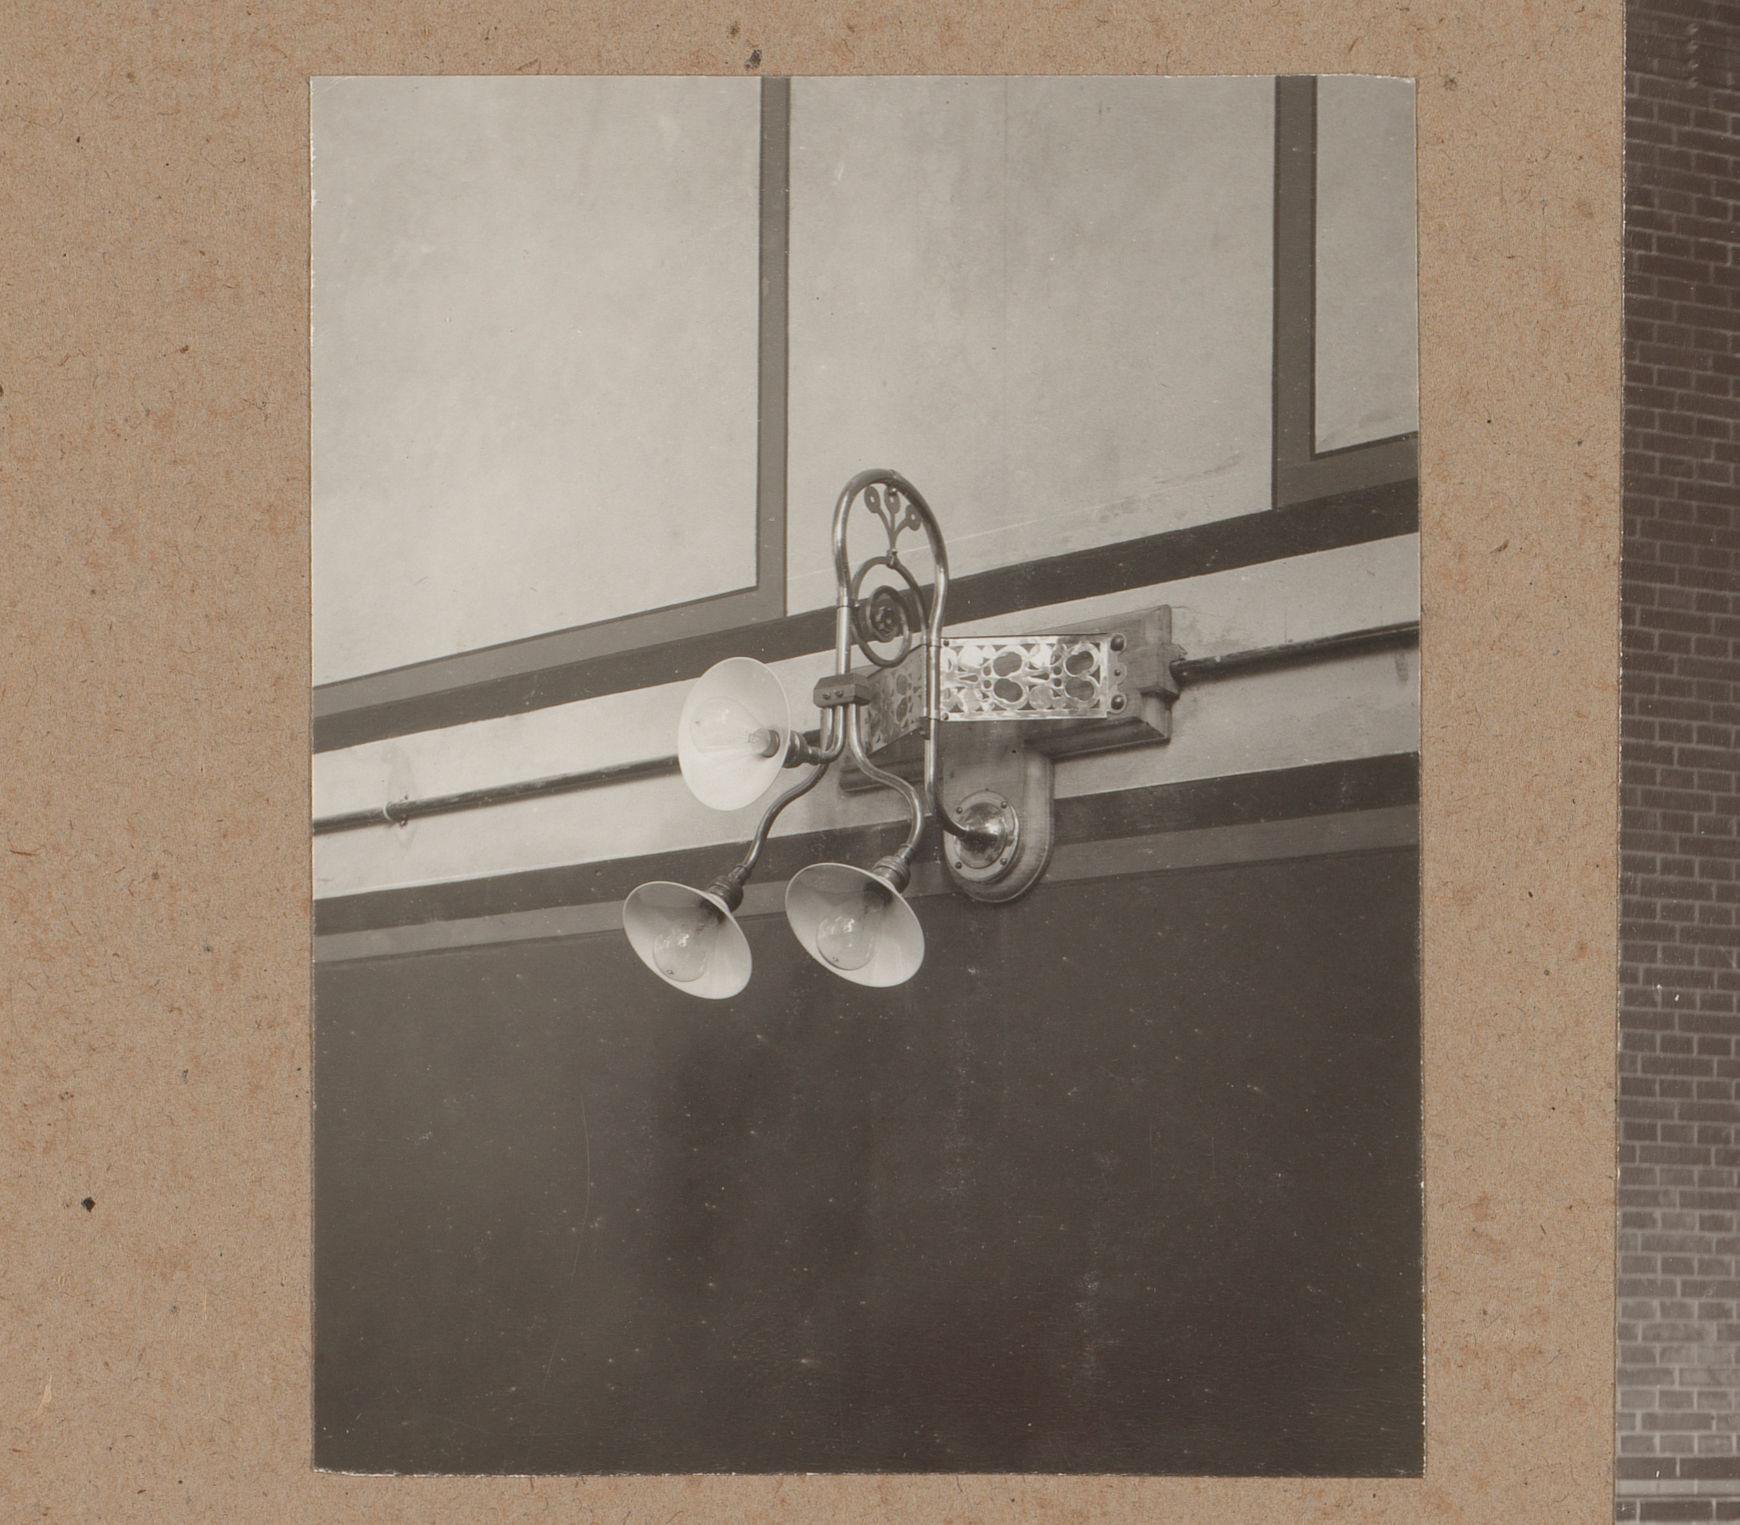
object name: photograph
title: Wandlamp in de Beurs van Berlage te Amsterdam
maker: Anonymous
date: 1903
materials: paper, cardboard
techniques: gelatin silver print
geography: amsterdam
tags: stock exchange, stock-market, electric lamp